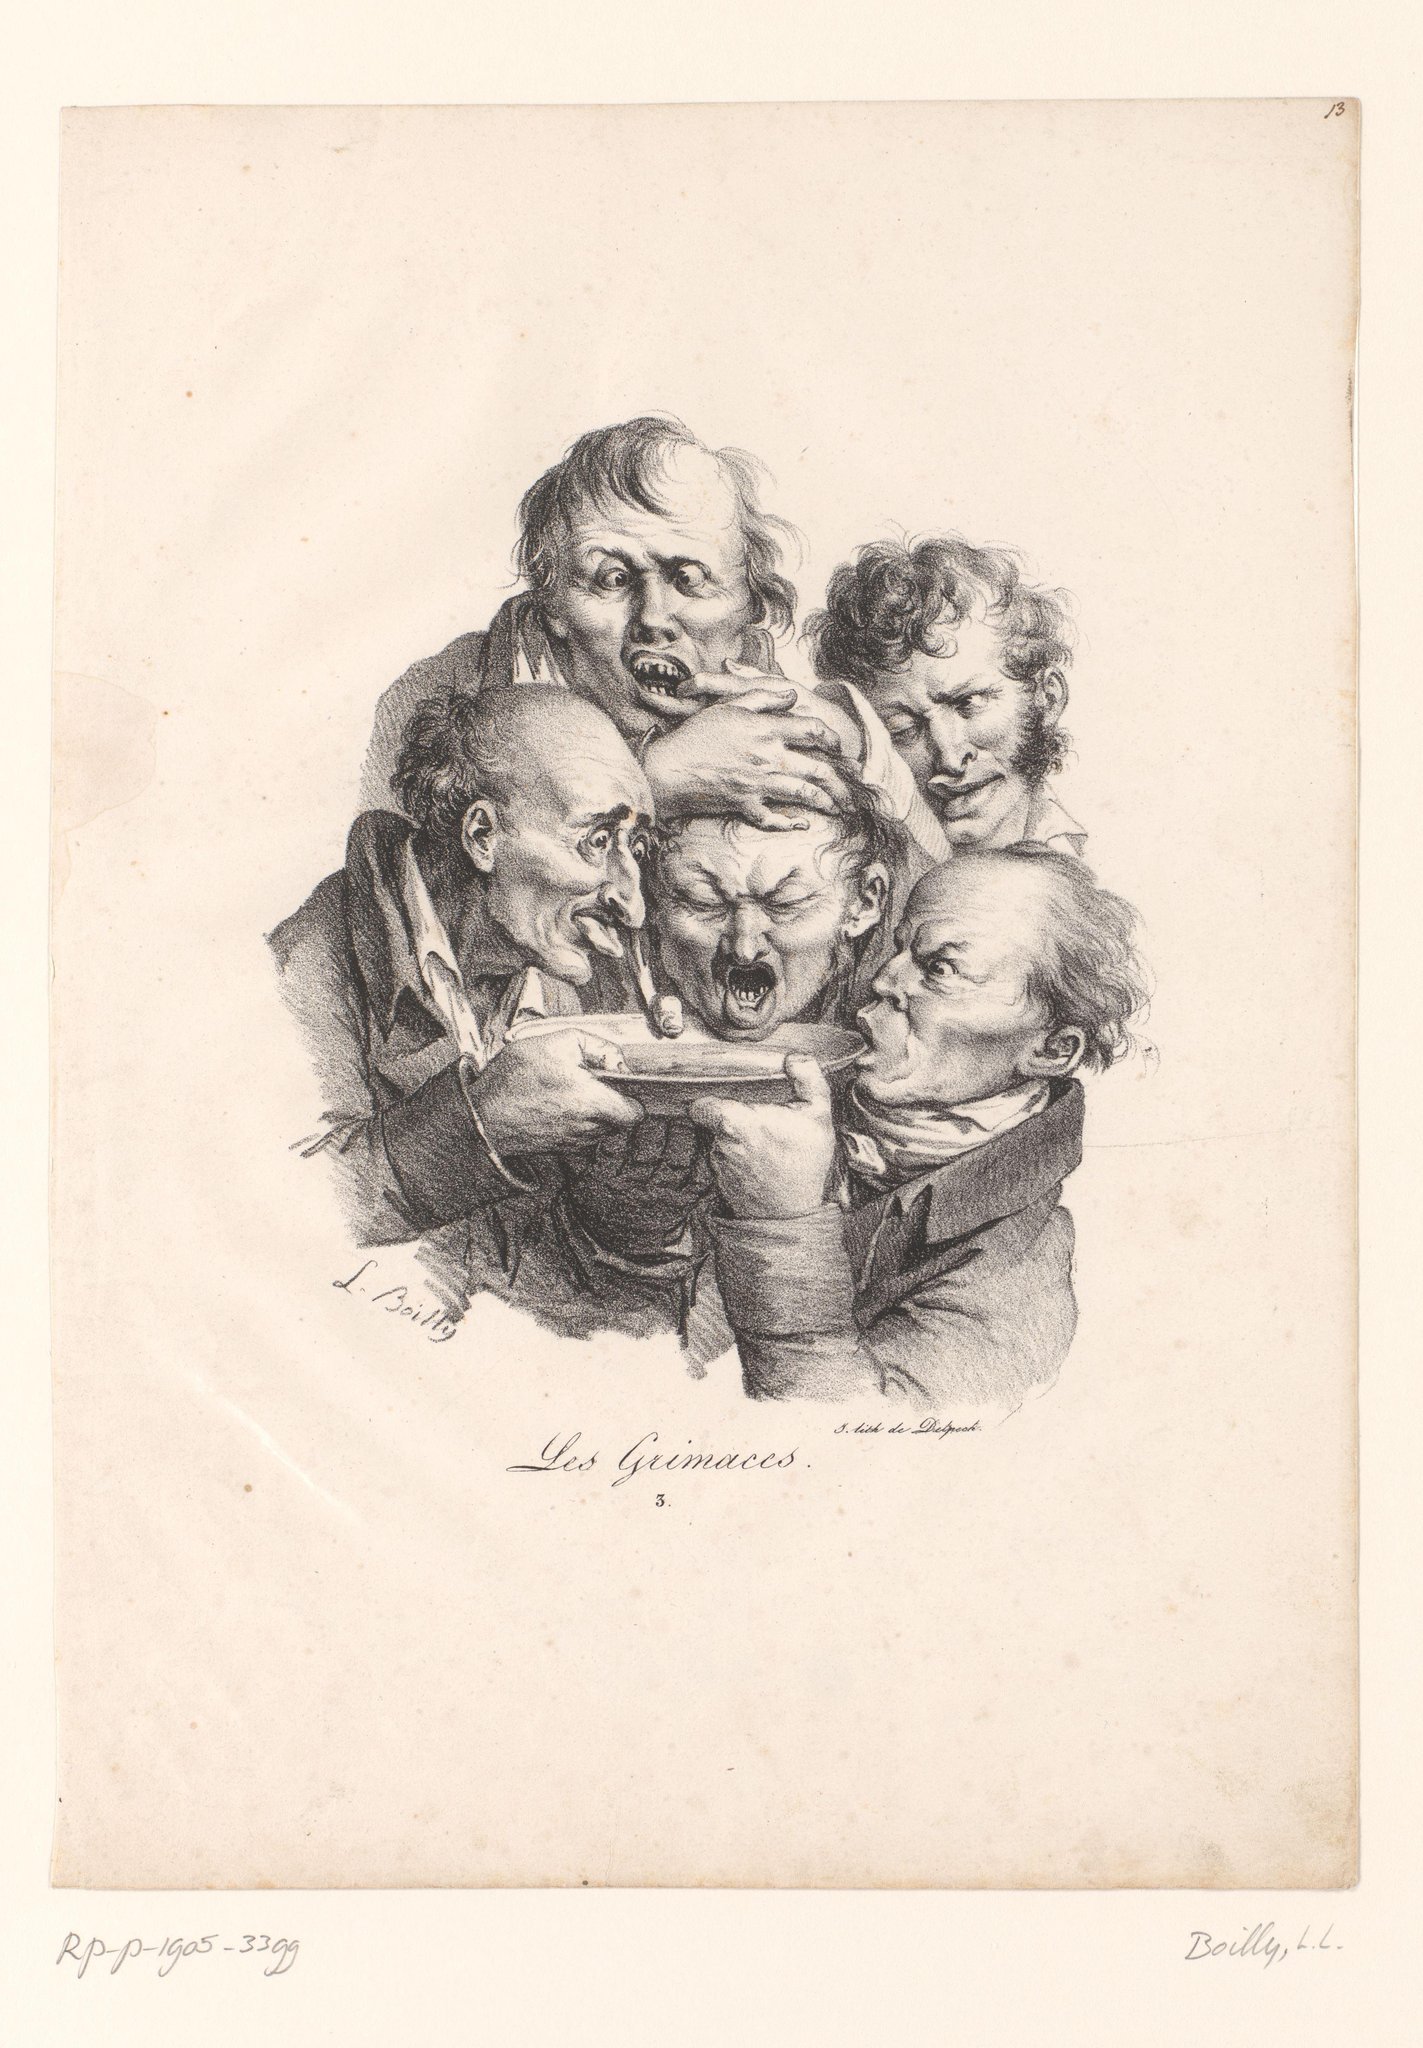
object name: cartoon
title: Recueil de grimaces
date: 1823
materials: paper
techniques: lithograph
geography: paris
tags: caricatures (human types), morphology of facial expression, dish, plate, saucer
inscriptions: number: ‘13’, collector's mark: Lugt 2228a